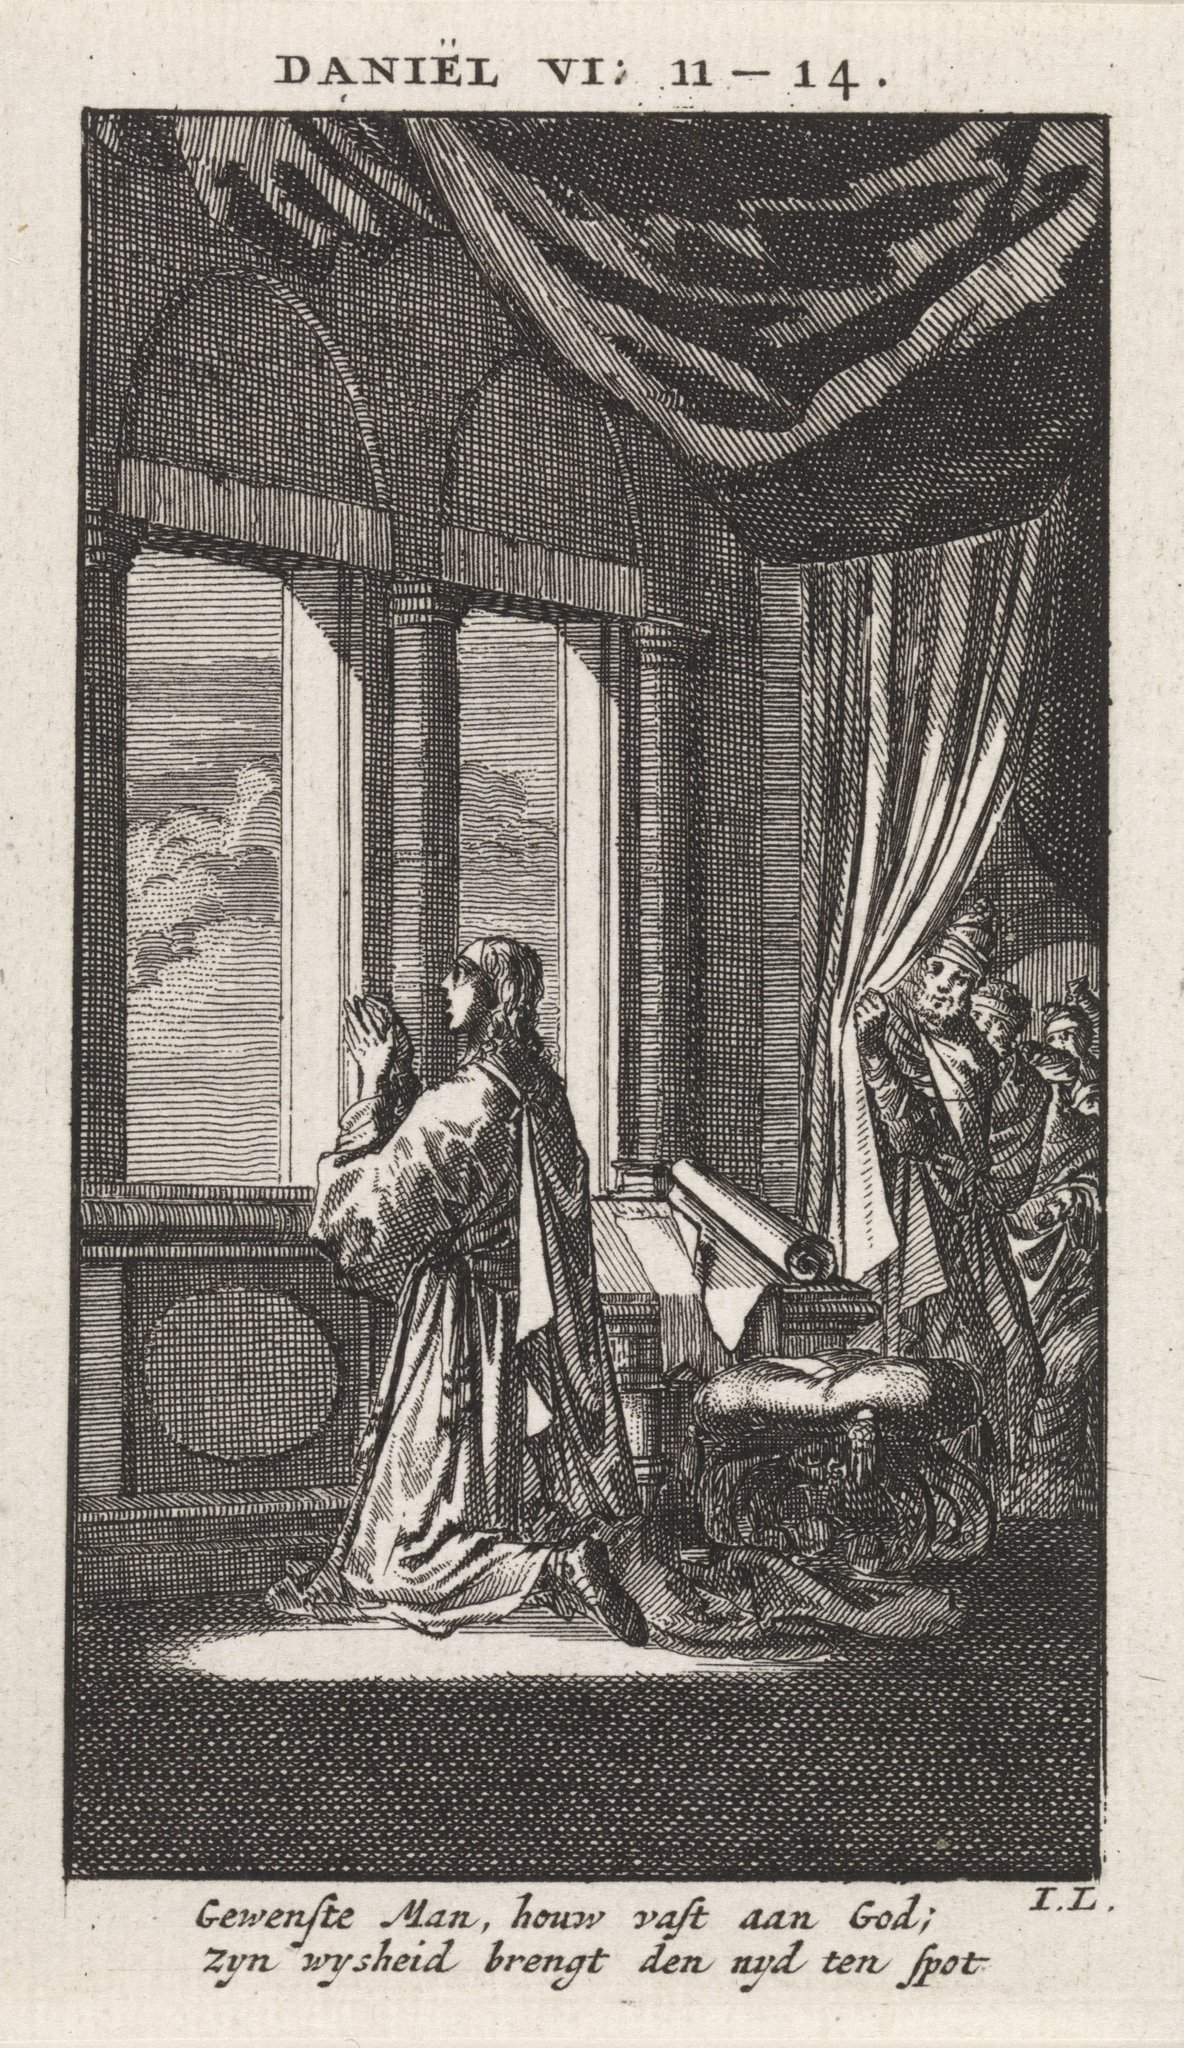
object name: book illustration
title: Daniël geknield voor een venster wordt bespied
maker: jan luyken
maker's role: draughtsman, print maker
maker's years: 1649-1712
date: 1712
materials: paper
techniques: etching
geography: amsterdam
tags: daniel, while praying on his knees before an open window, is discovered by the conspirators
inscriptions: collector's mark: Lugt 2228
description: Illustratie voor: Luyken, Jan. Bybel printen. Amsterdam: Pieter Arentsz. II (wed.) en Cornelis van der Sys, 1712, p. 16.